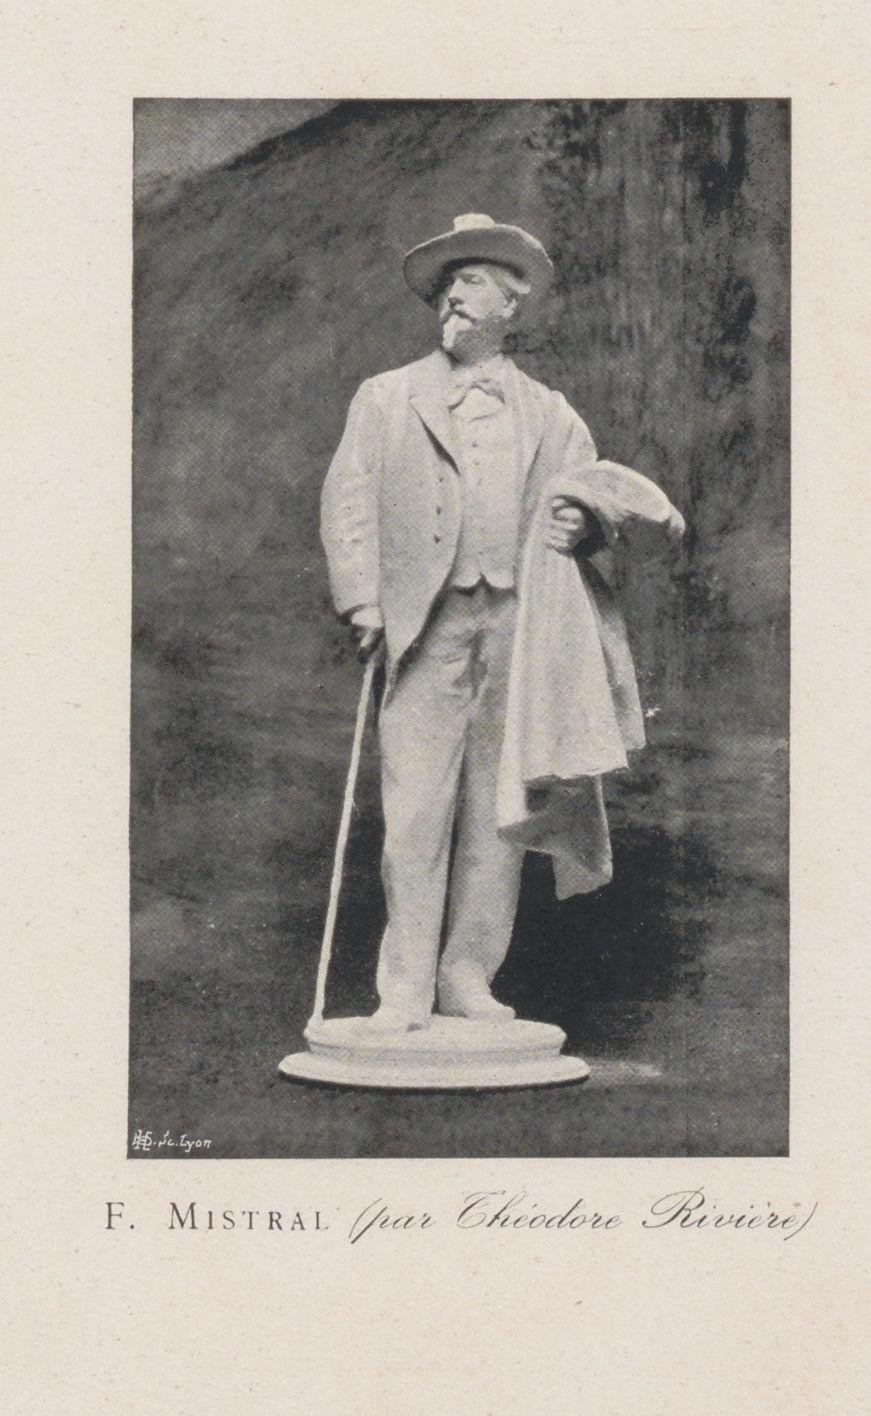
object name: letter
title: Brief aan Philip Zilcken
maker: frédéric mistral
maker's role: schrijver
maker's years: 1830-1914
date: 1906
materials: ink, paper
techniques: pen, printing, writing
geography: maillane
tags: painter, draughtsman, philip zilcken, printed matter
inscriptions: collector's mark: ‘RPK’